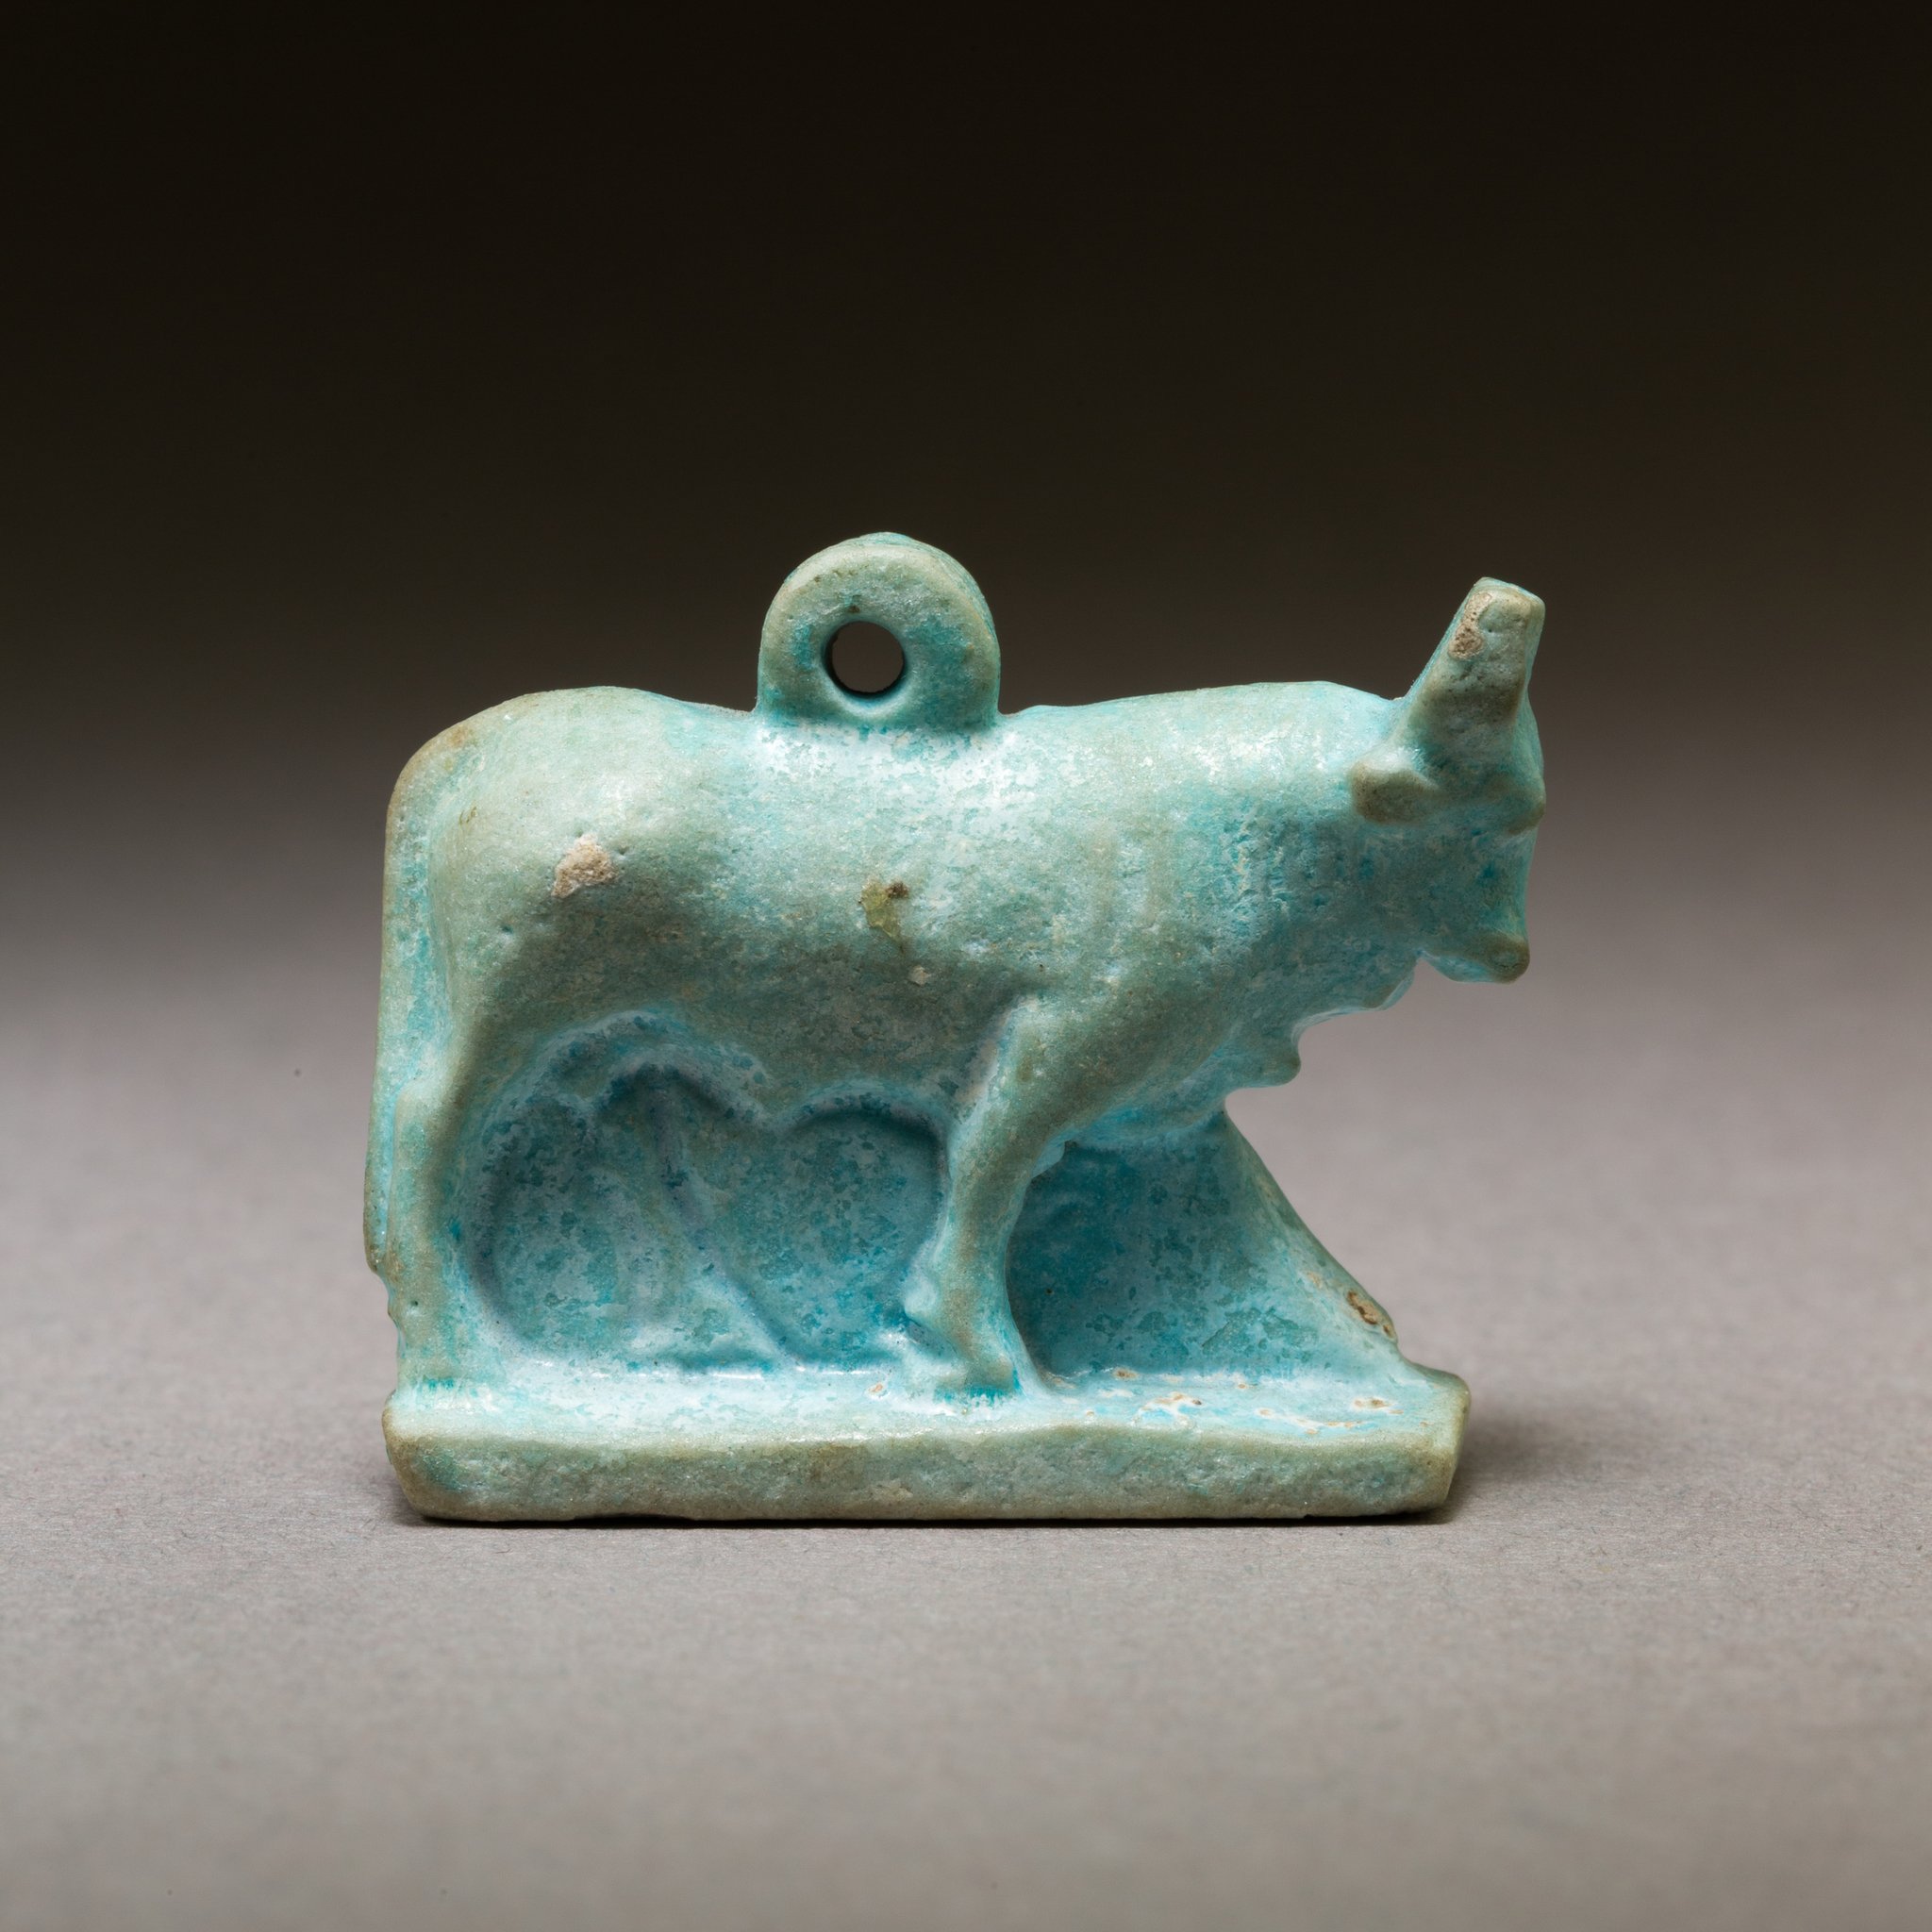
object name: amulet, bull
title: Bull amulet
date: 664-630 BCE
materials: faience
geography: egypt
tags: bulls